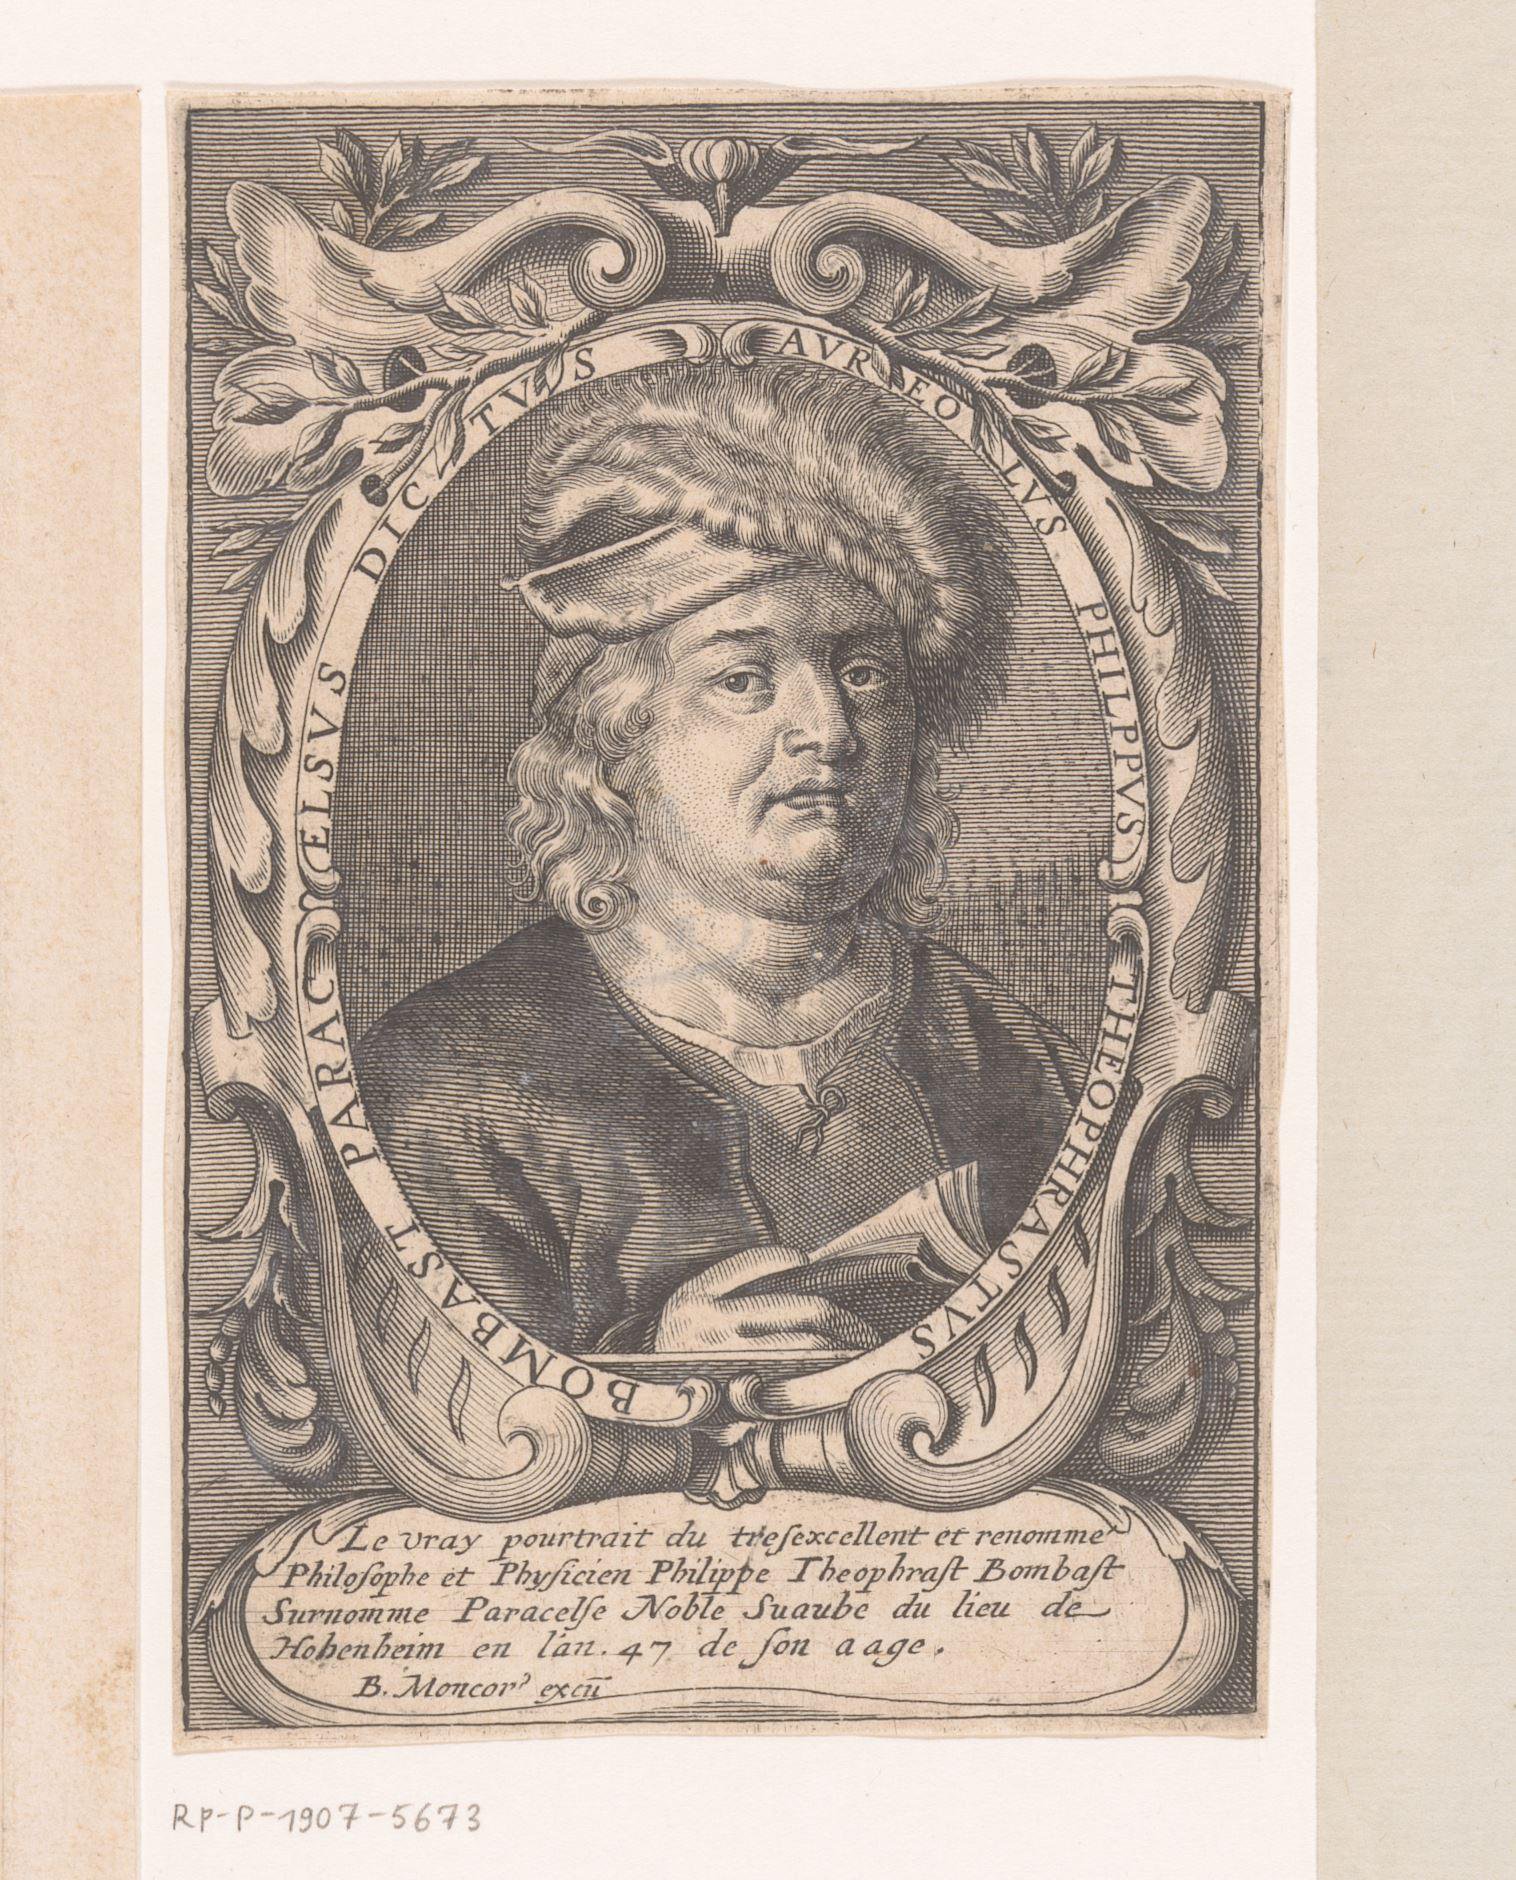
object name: print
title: Portret van Philippus Aureolus Theophrastus Bombastus von Hohenheim of Paracelsus op 47-jarige leeftijd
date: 1610-1668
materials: paper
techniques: engraving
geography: paris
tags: theologian, historical persons, physician, doctor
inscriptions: collector's mark: Lugt 2228